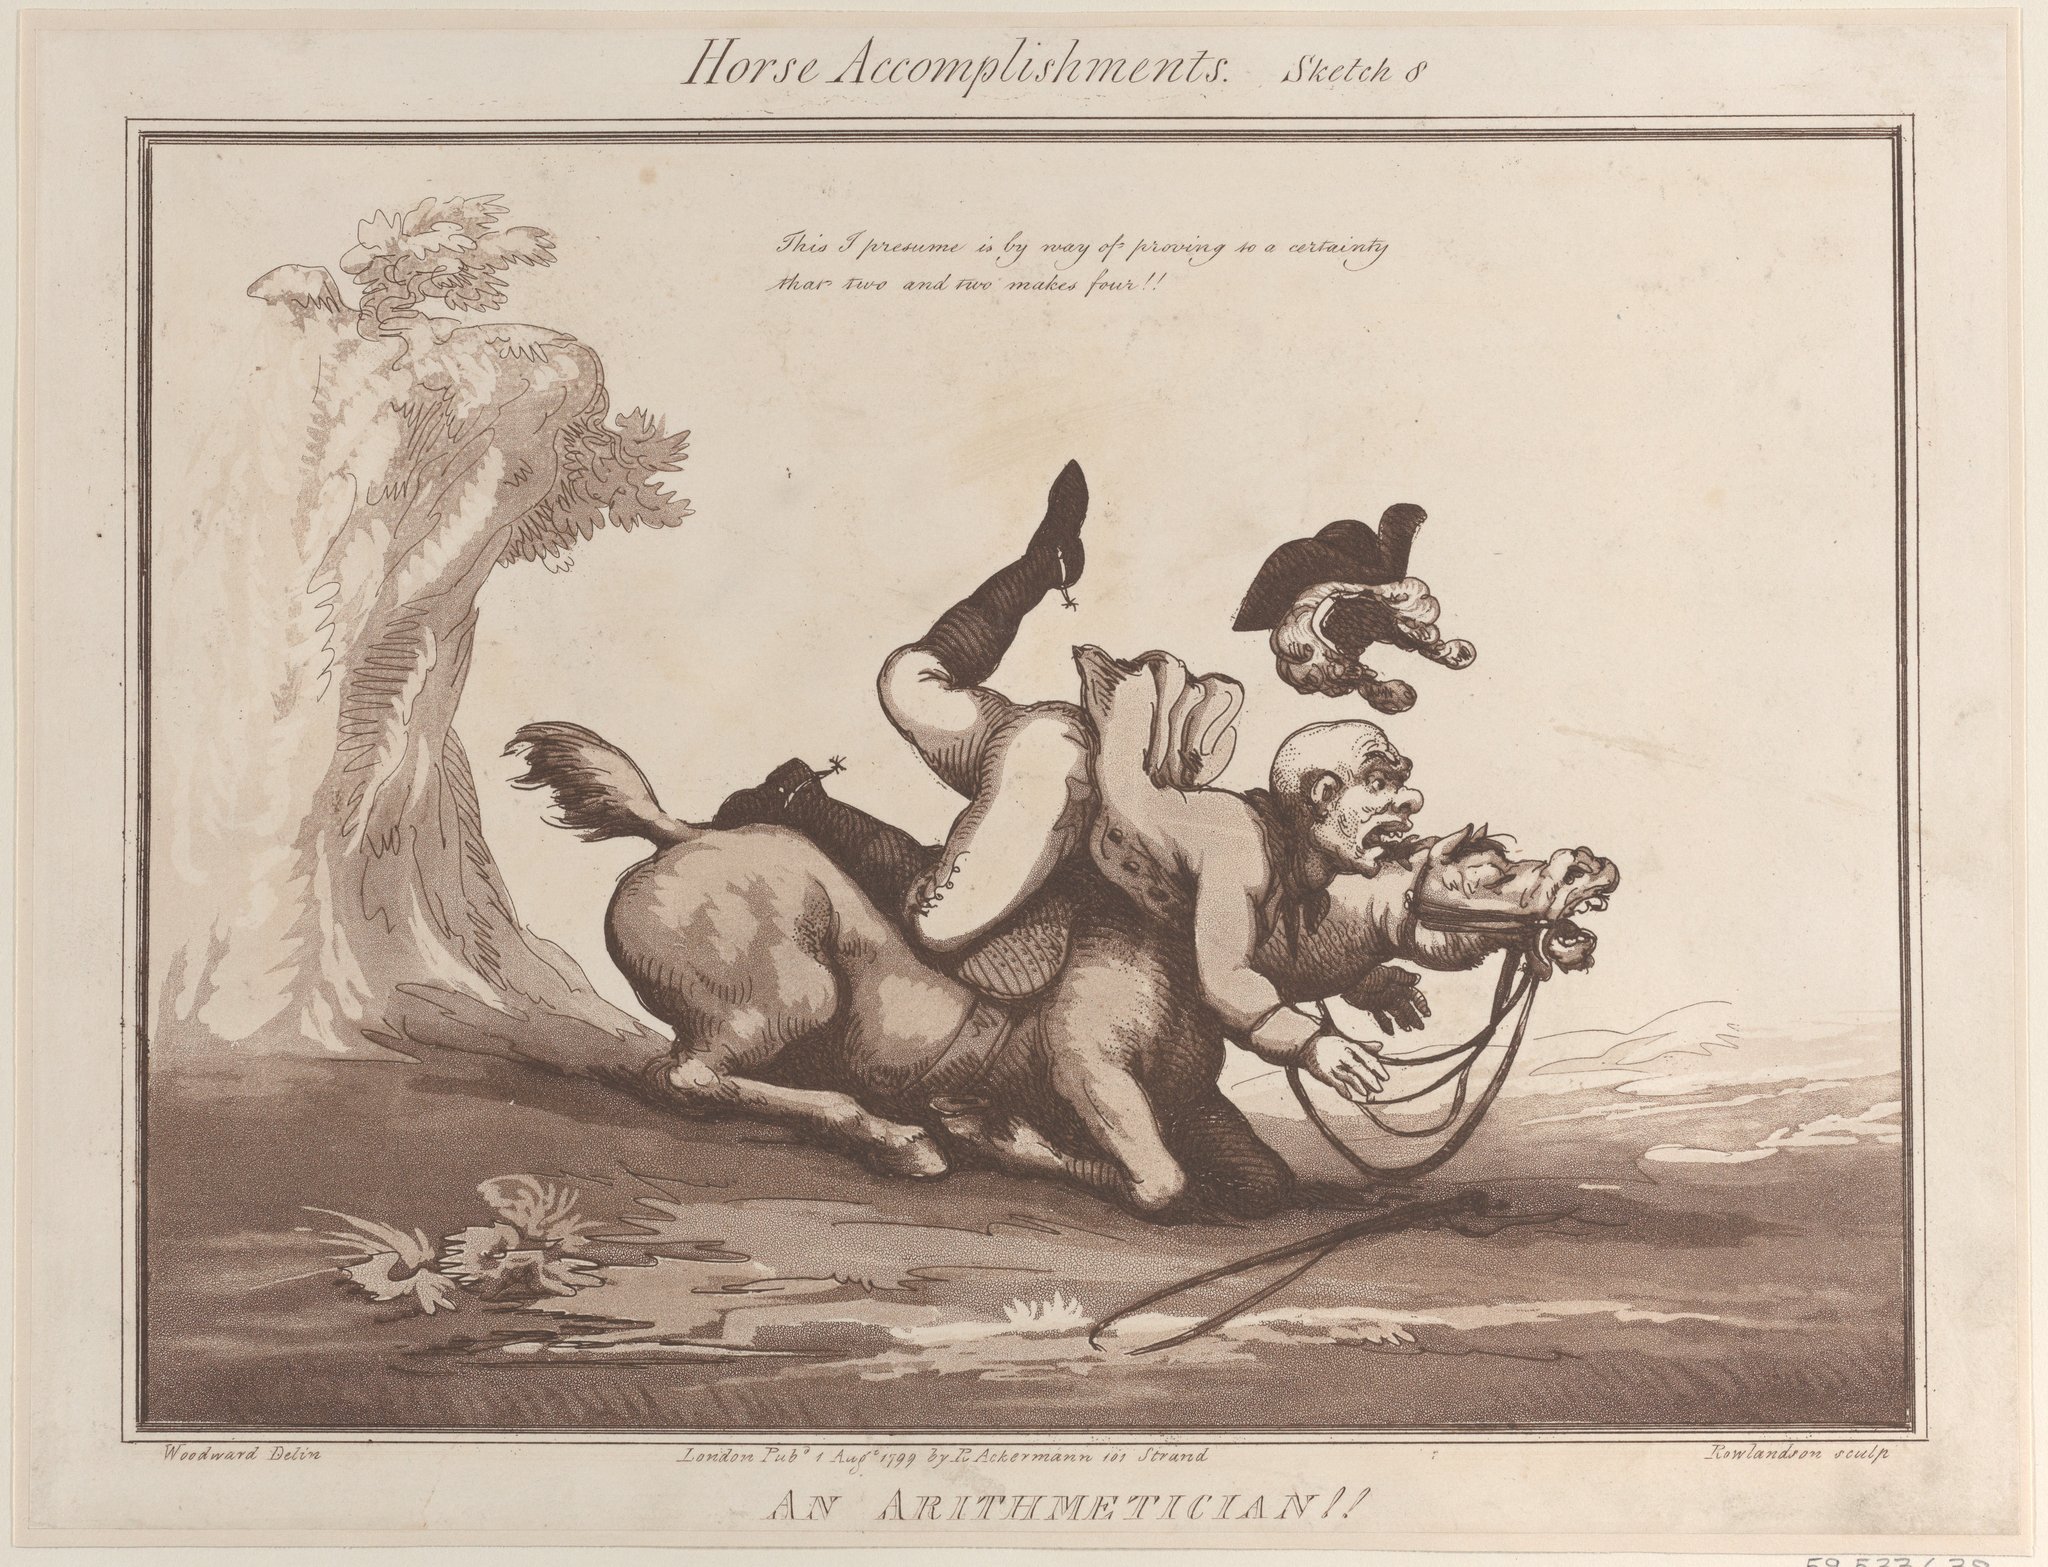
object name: print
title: Horse Accomplishments, Sketch 8: An Arithmetician !!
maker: thomas rowlandson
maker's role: artist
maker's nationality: british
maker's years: 1757-1827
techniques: aquatint, etching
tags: satire,men,horses,caricature